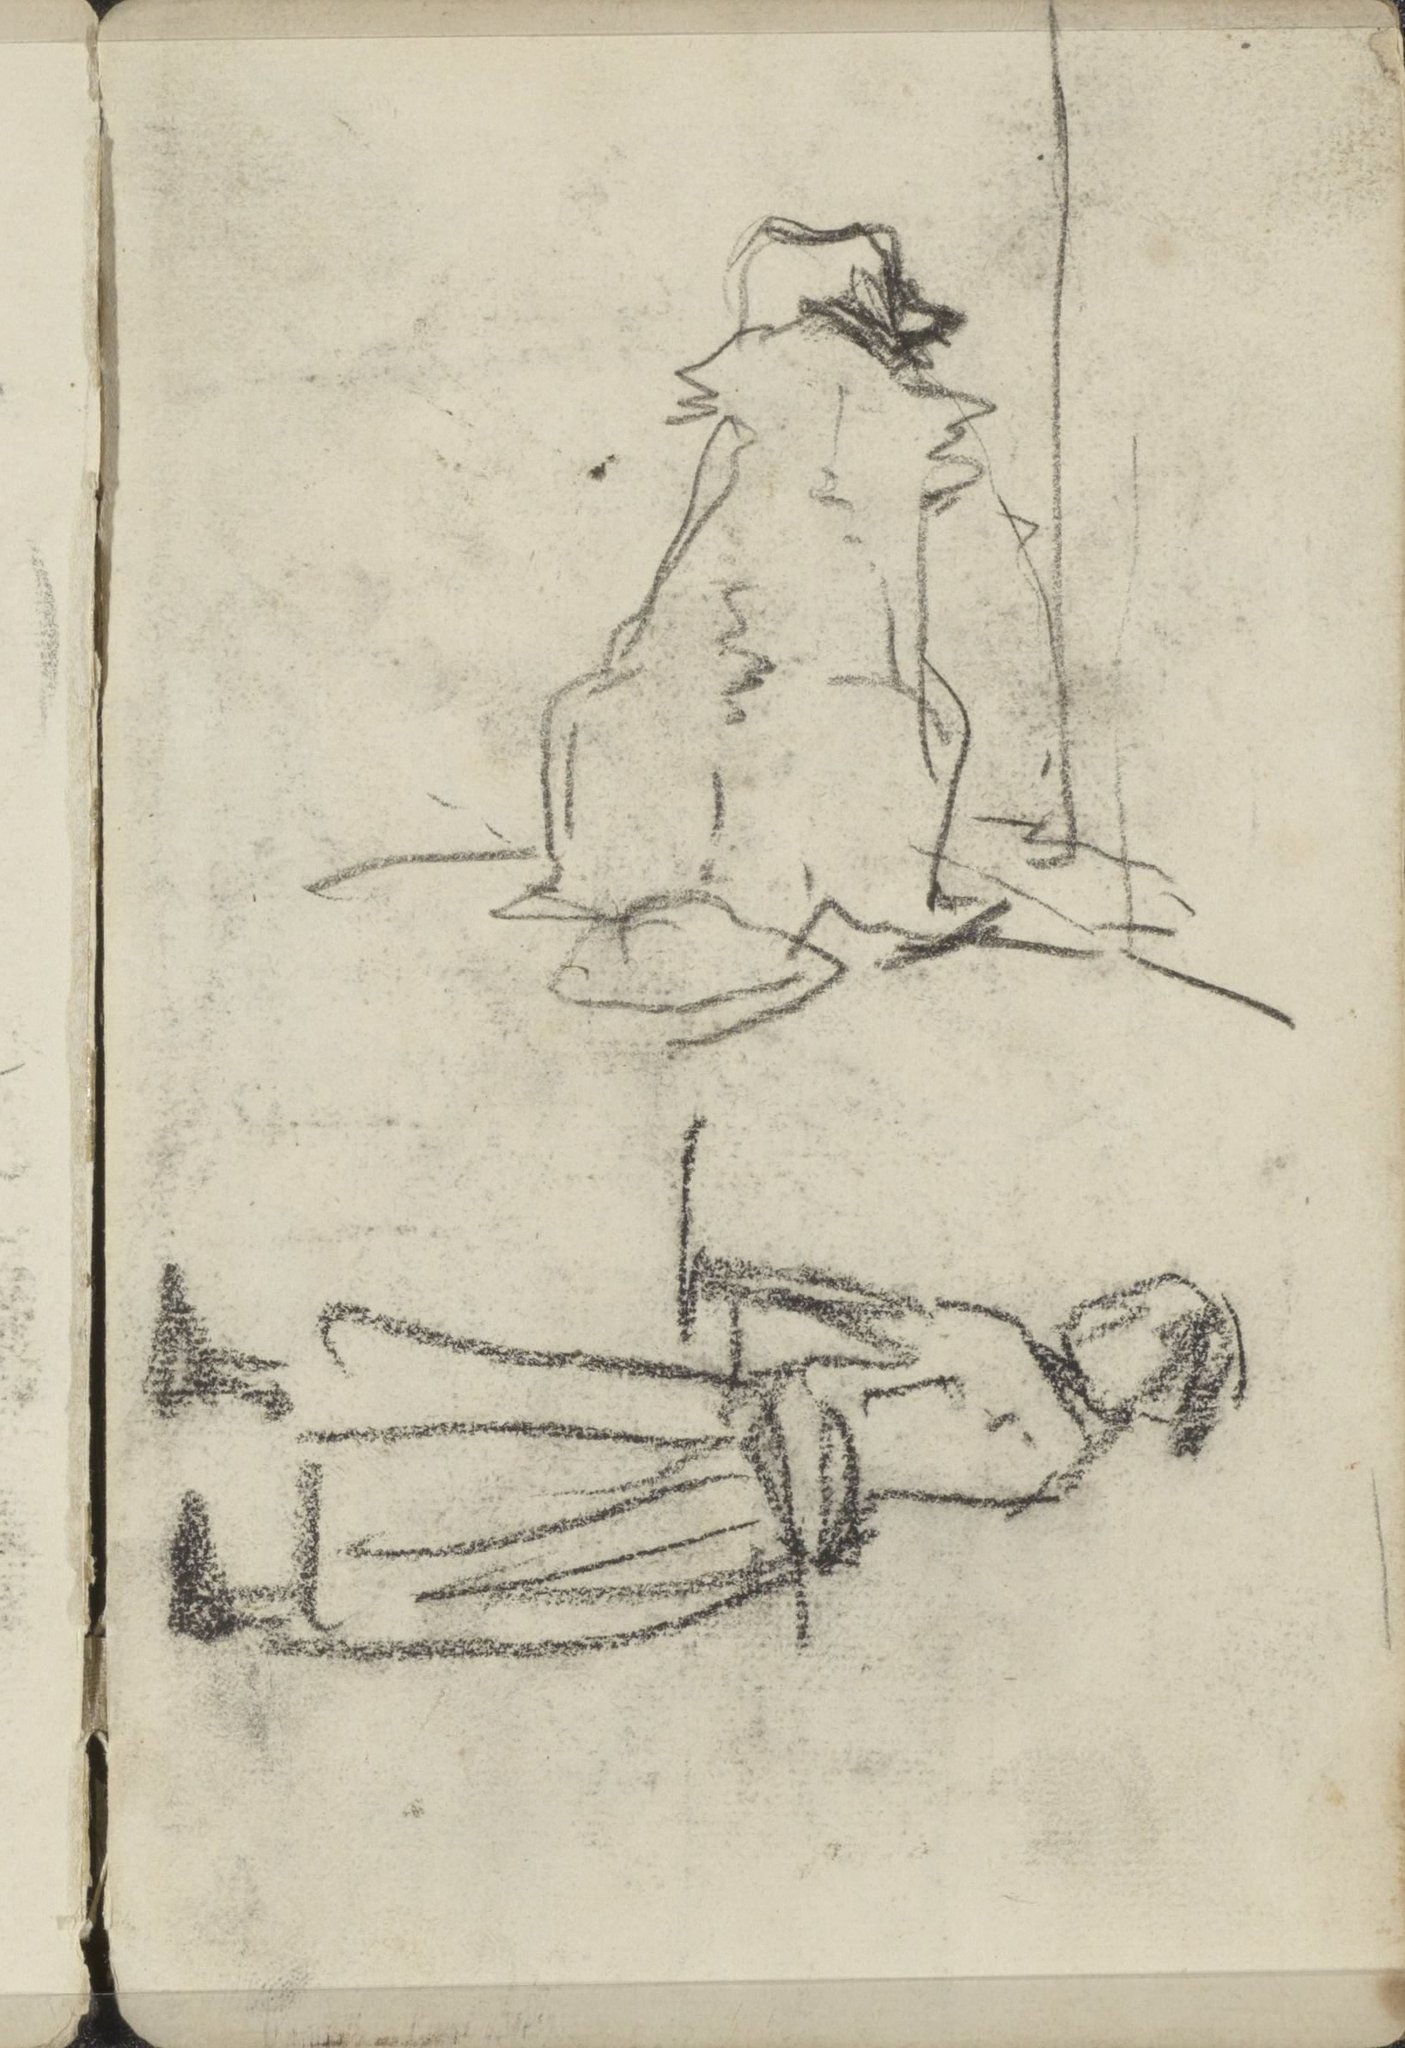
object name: sketchbook leaf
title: Figuurstudies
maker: george hendrik breitner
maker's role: draughtsman, painter, print maker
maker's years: 1857-1923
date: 1886-1903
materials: chalk, paper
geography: amsterdam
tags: adolescent, young woman, maiden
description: Pagina 26 uit een schetsboek met 15 bladen.